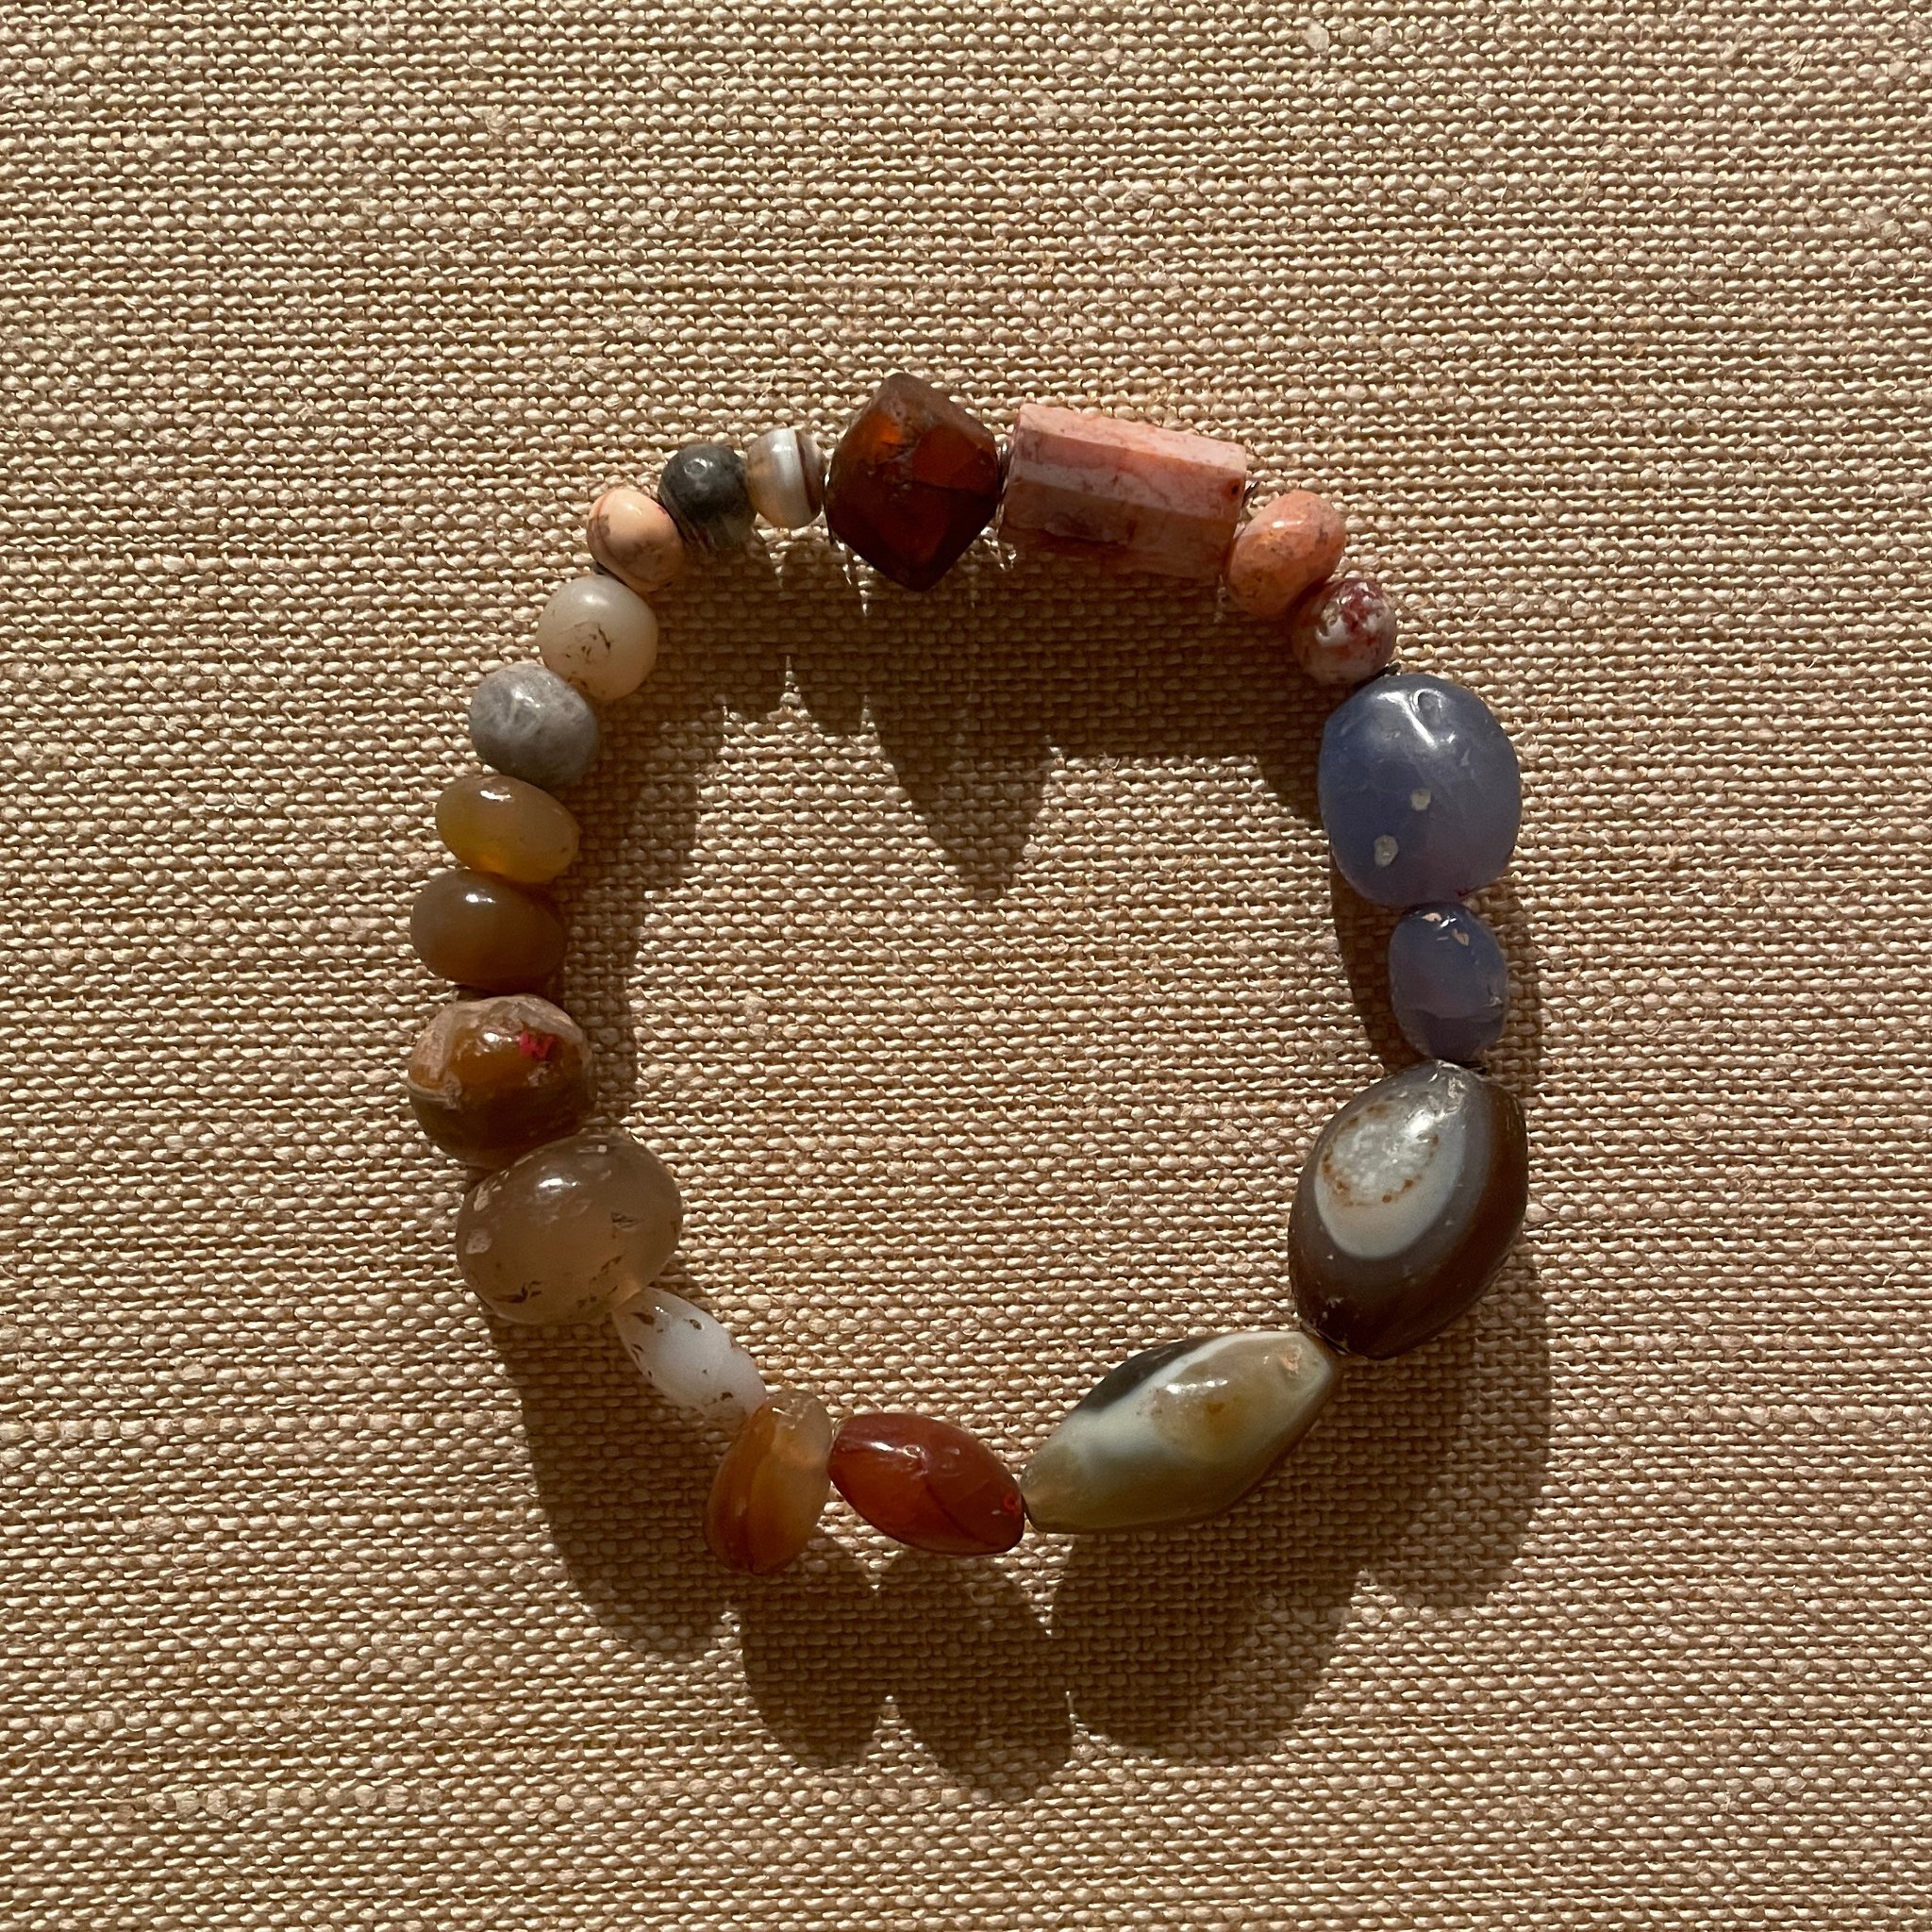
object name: bead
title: Beads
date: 801-1200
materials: stone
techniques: cutting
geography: iran